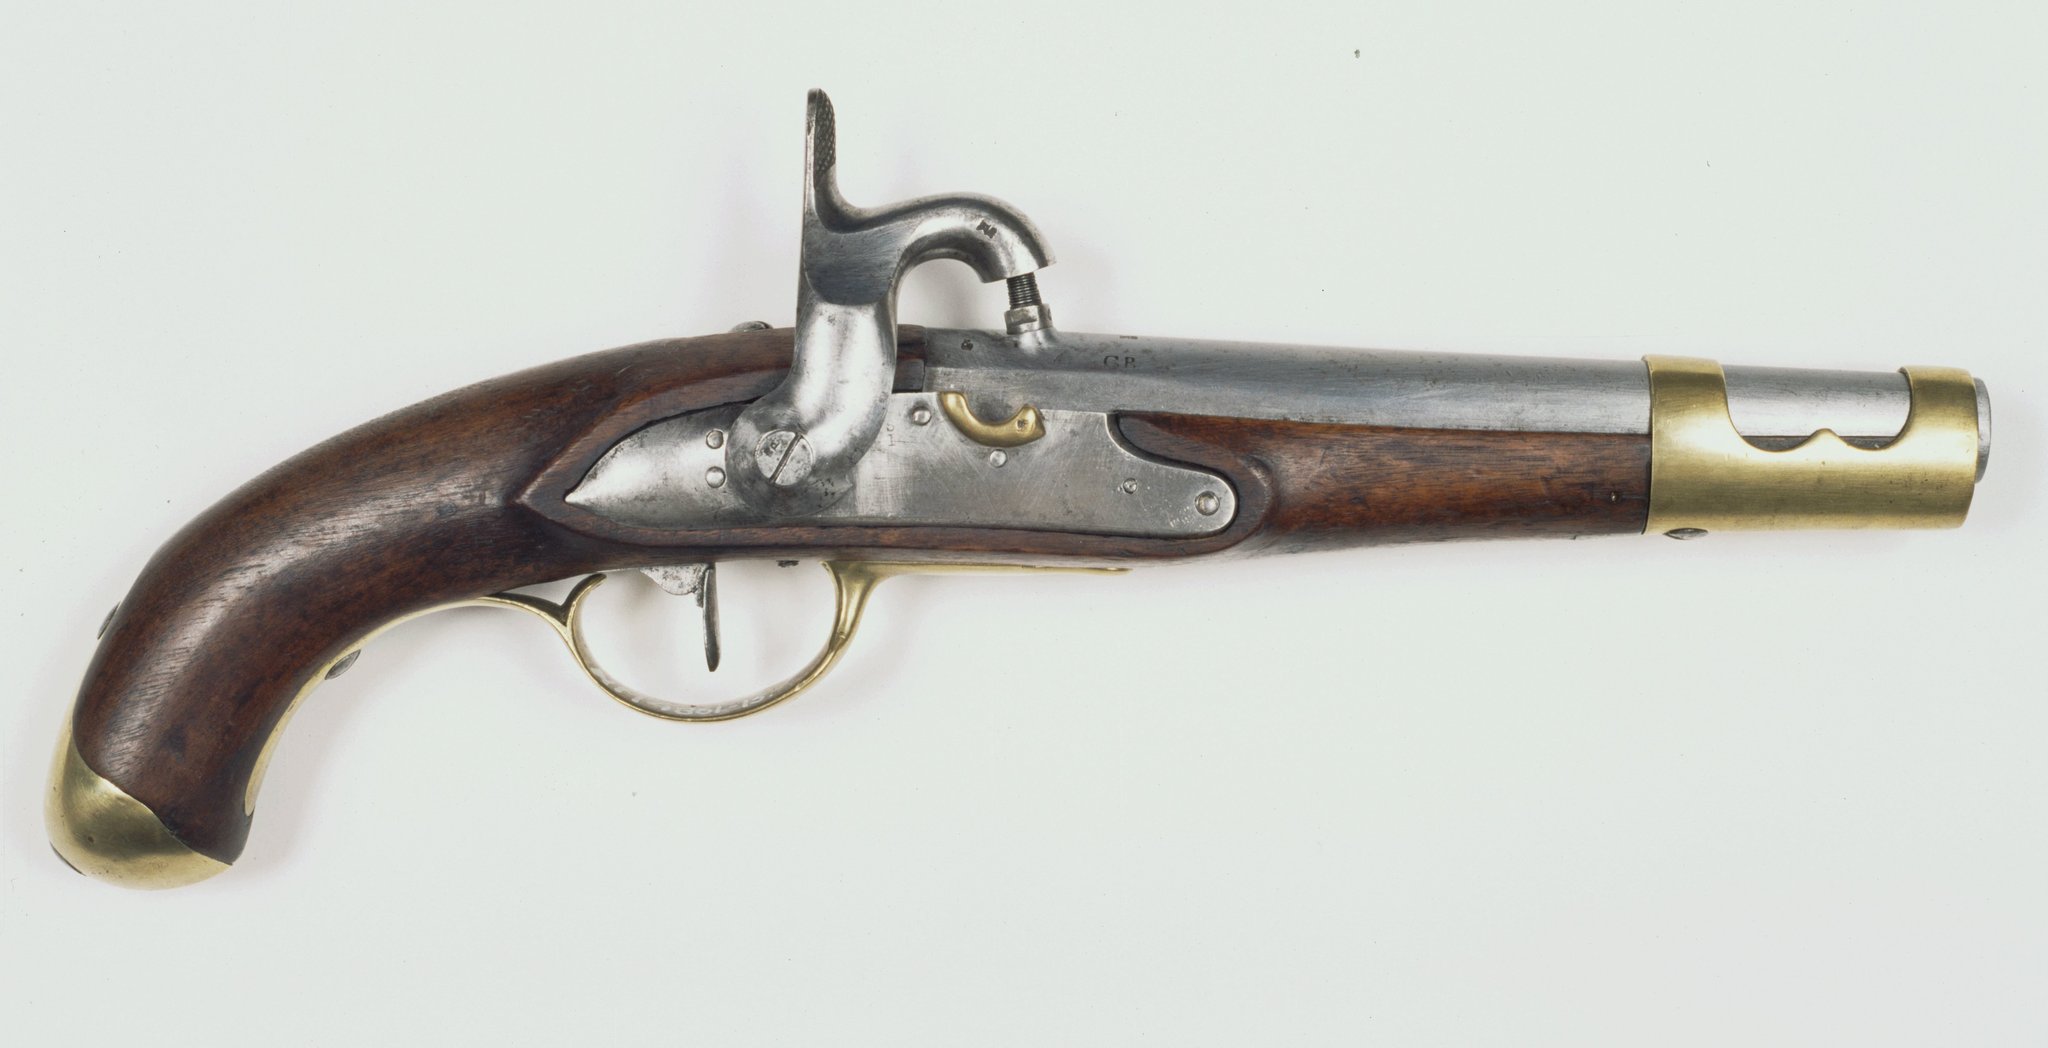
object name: percussion pistol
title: Percussie legerpistool model M 1815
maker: Anonymous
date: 1815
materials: brass, iron, wood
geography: western europe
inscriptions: signature: ‘IS met kroon’, signature: ‘K met kroon’, signature: ‘H met kroon’, signature: ‘H met kroon’